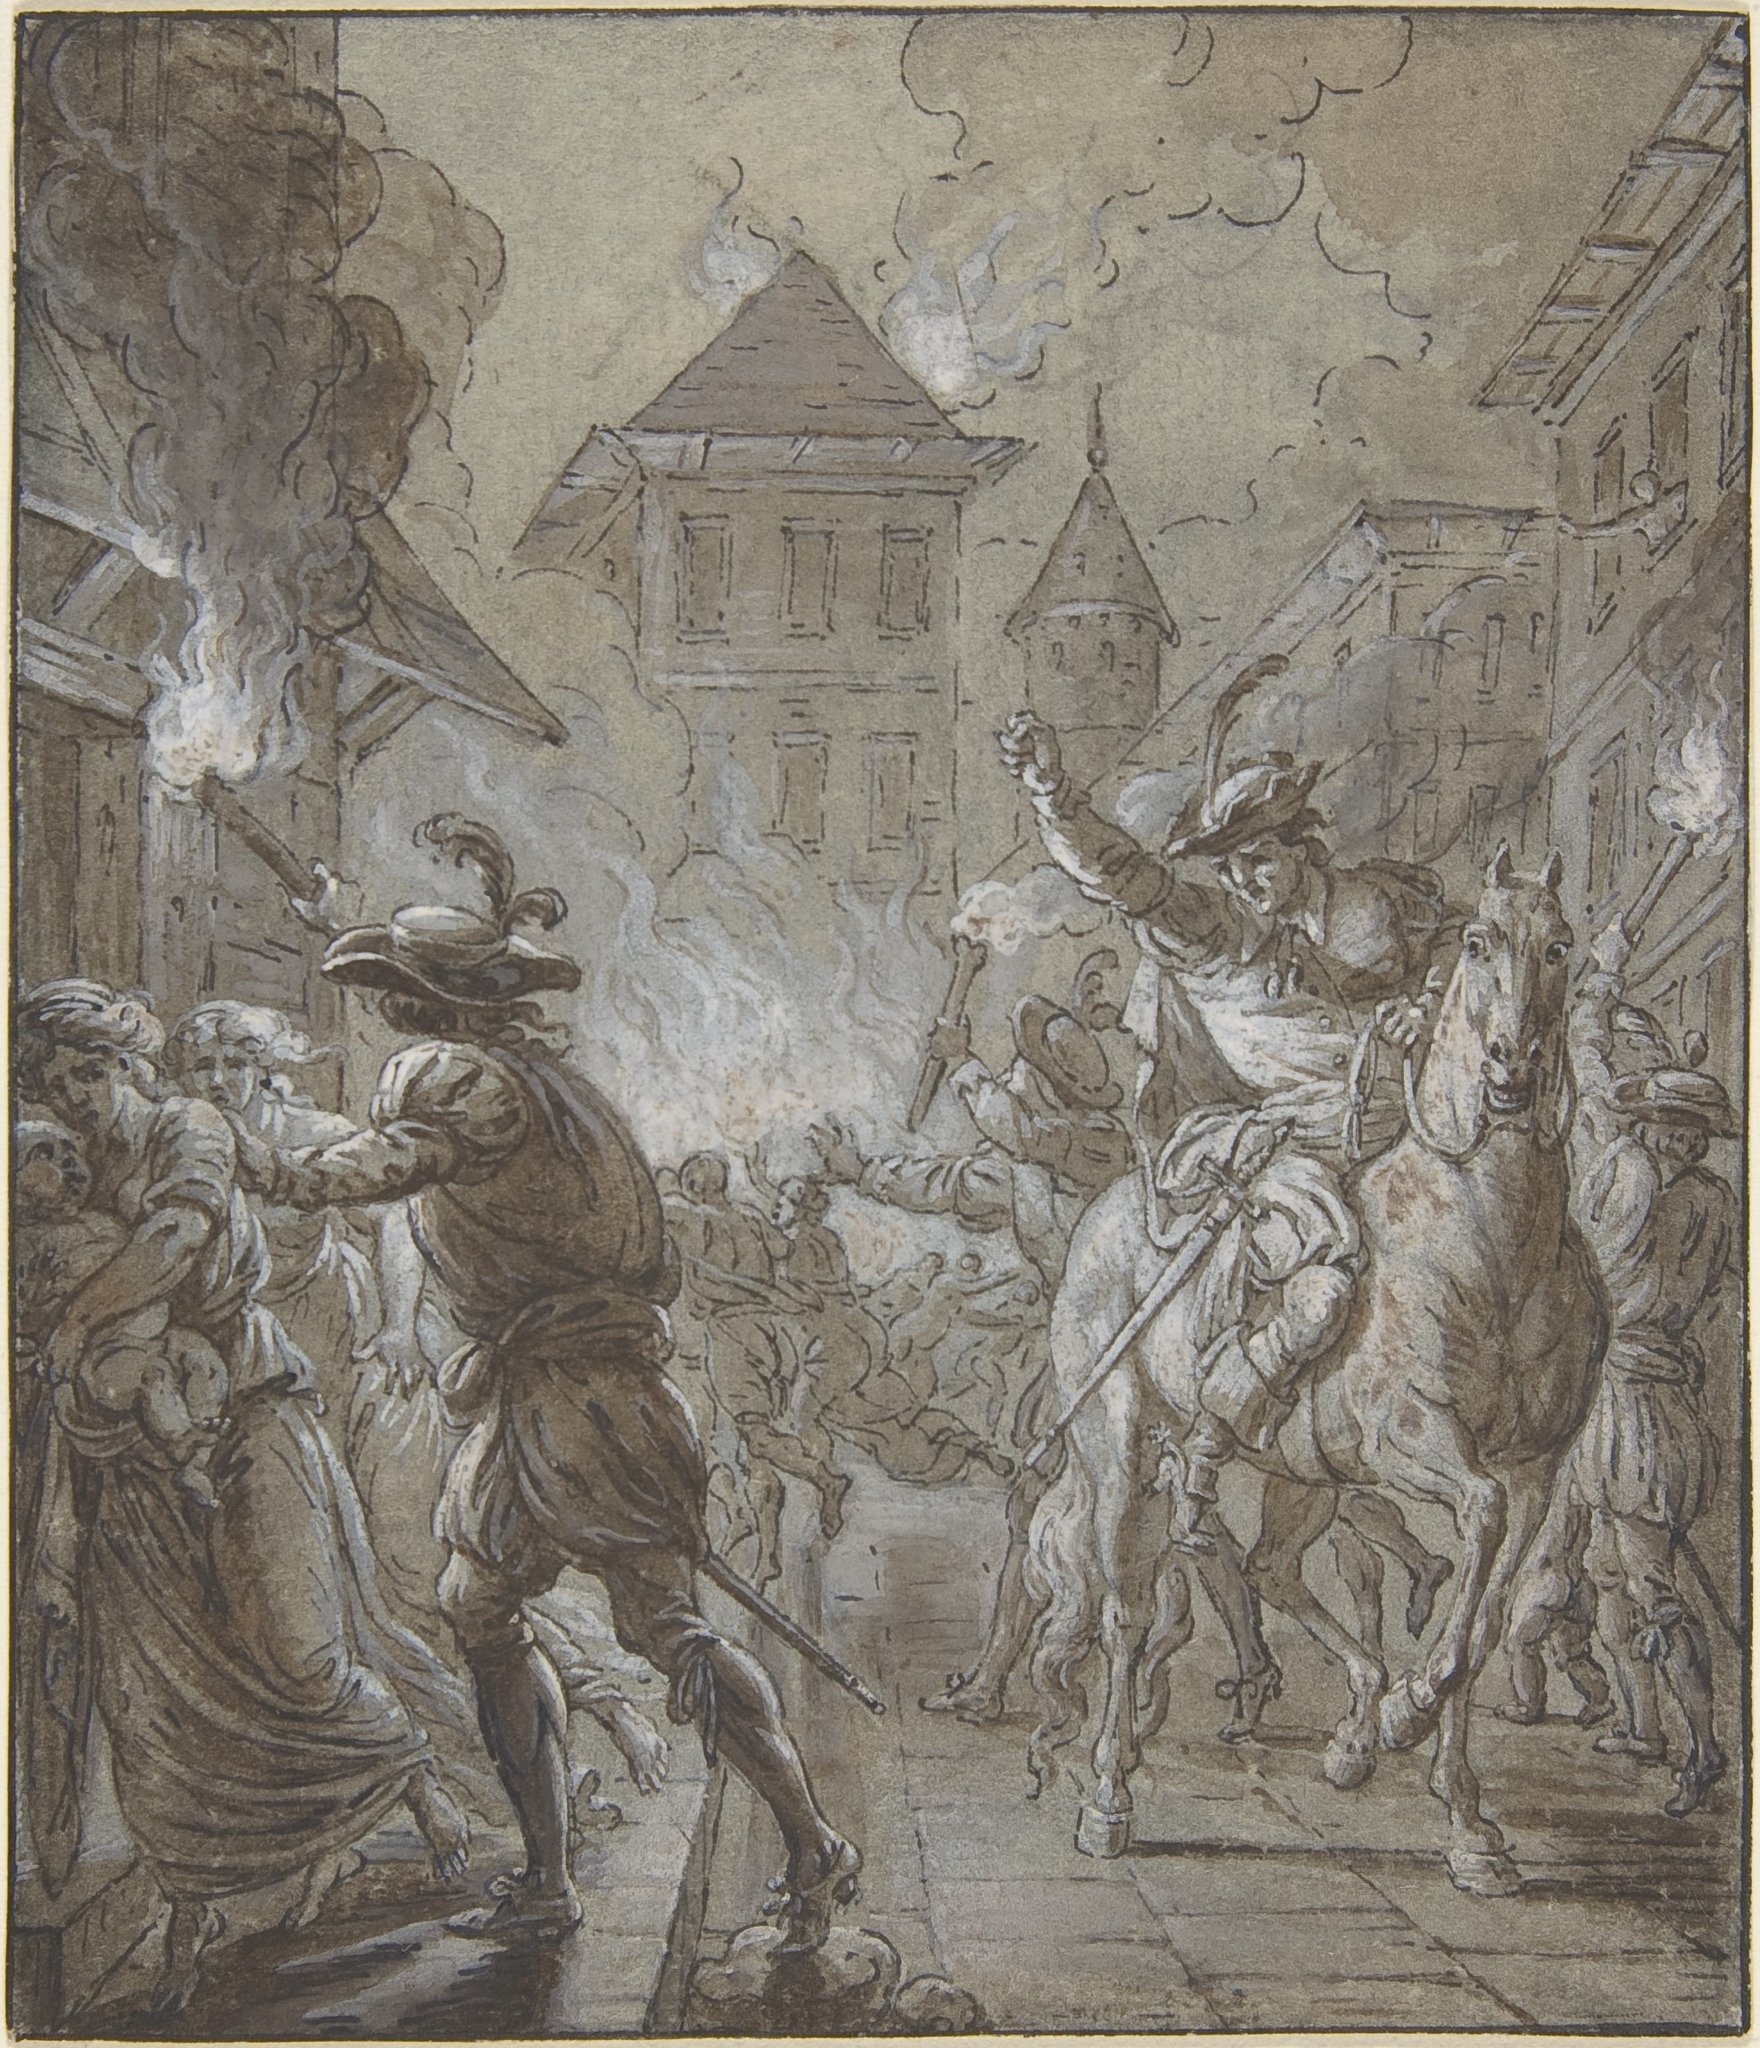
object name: drawing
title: Soldiers pillaging a town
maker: anonymous, 17th century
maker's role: artist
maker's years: 1600-1700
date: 1601-1700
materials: ink, paper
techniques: brush, heightening, pen, wash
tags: soldiers,infants,women,horses,fire